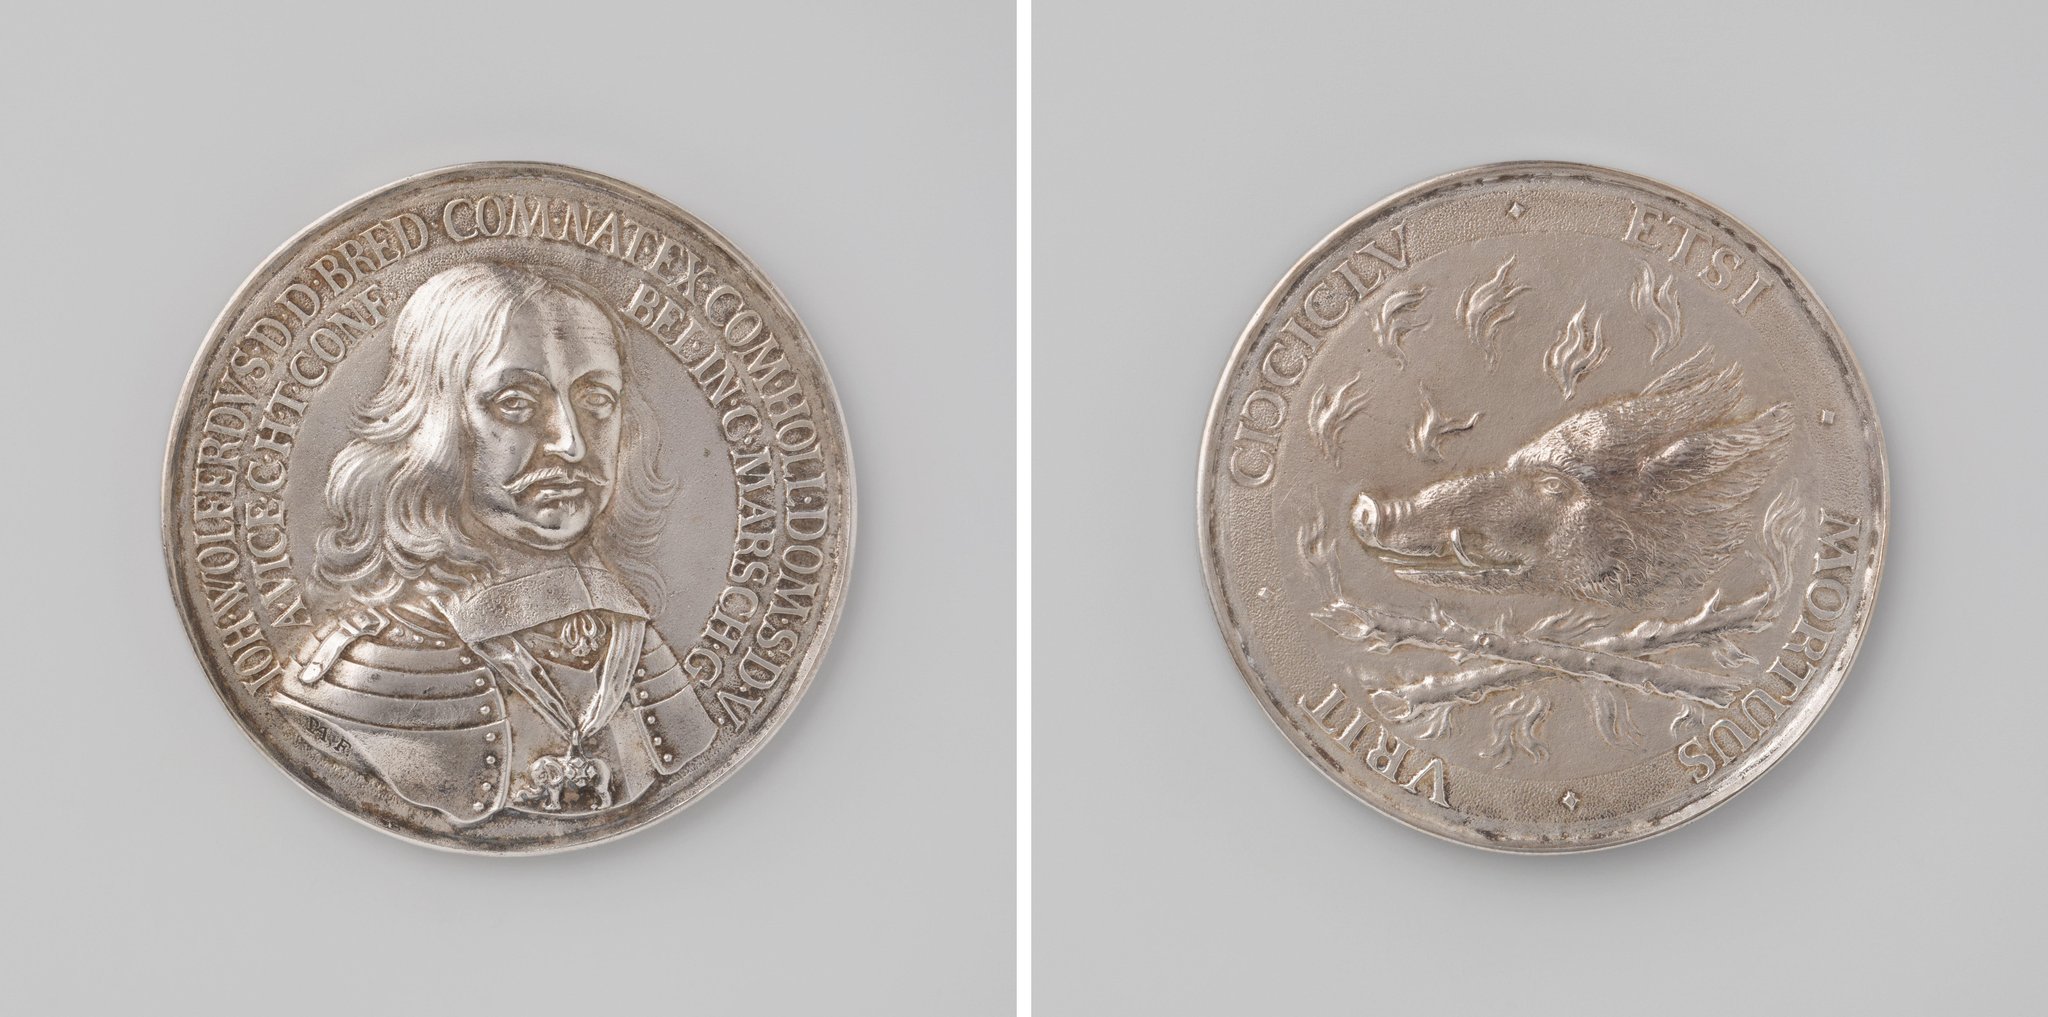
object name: overlijdenspenning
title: Overlijden van Johan Wolfert van Brederode, veldmaarschalk der Nederlanden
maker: pieter van abeele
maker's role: draughtsman, jeweler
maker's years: 1608-1684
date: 1655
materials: silver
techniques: striking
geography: amsterdam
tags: vianen, joan wolfert van brederode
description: Zilveren penning. Voorzijde: borststuk man binnen dubbel omschrift. Keerzijde: kop van everzwijn boven twee gekruiste brandende takken binnen omschrift.